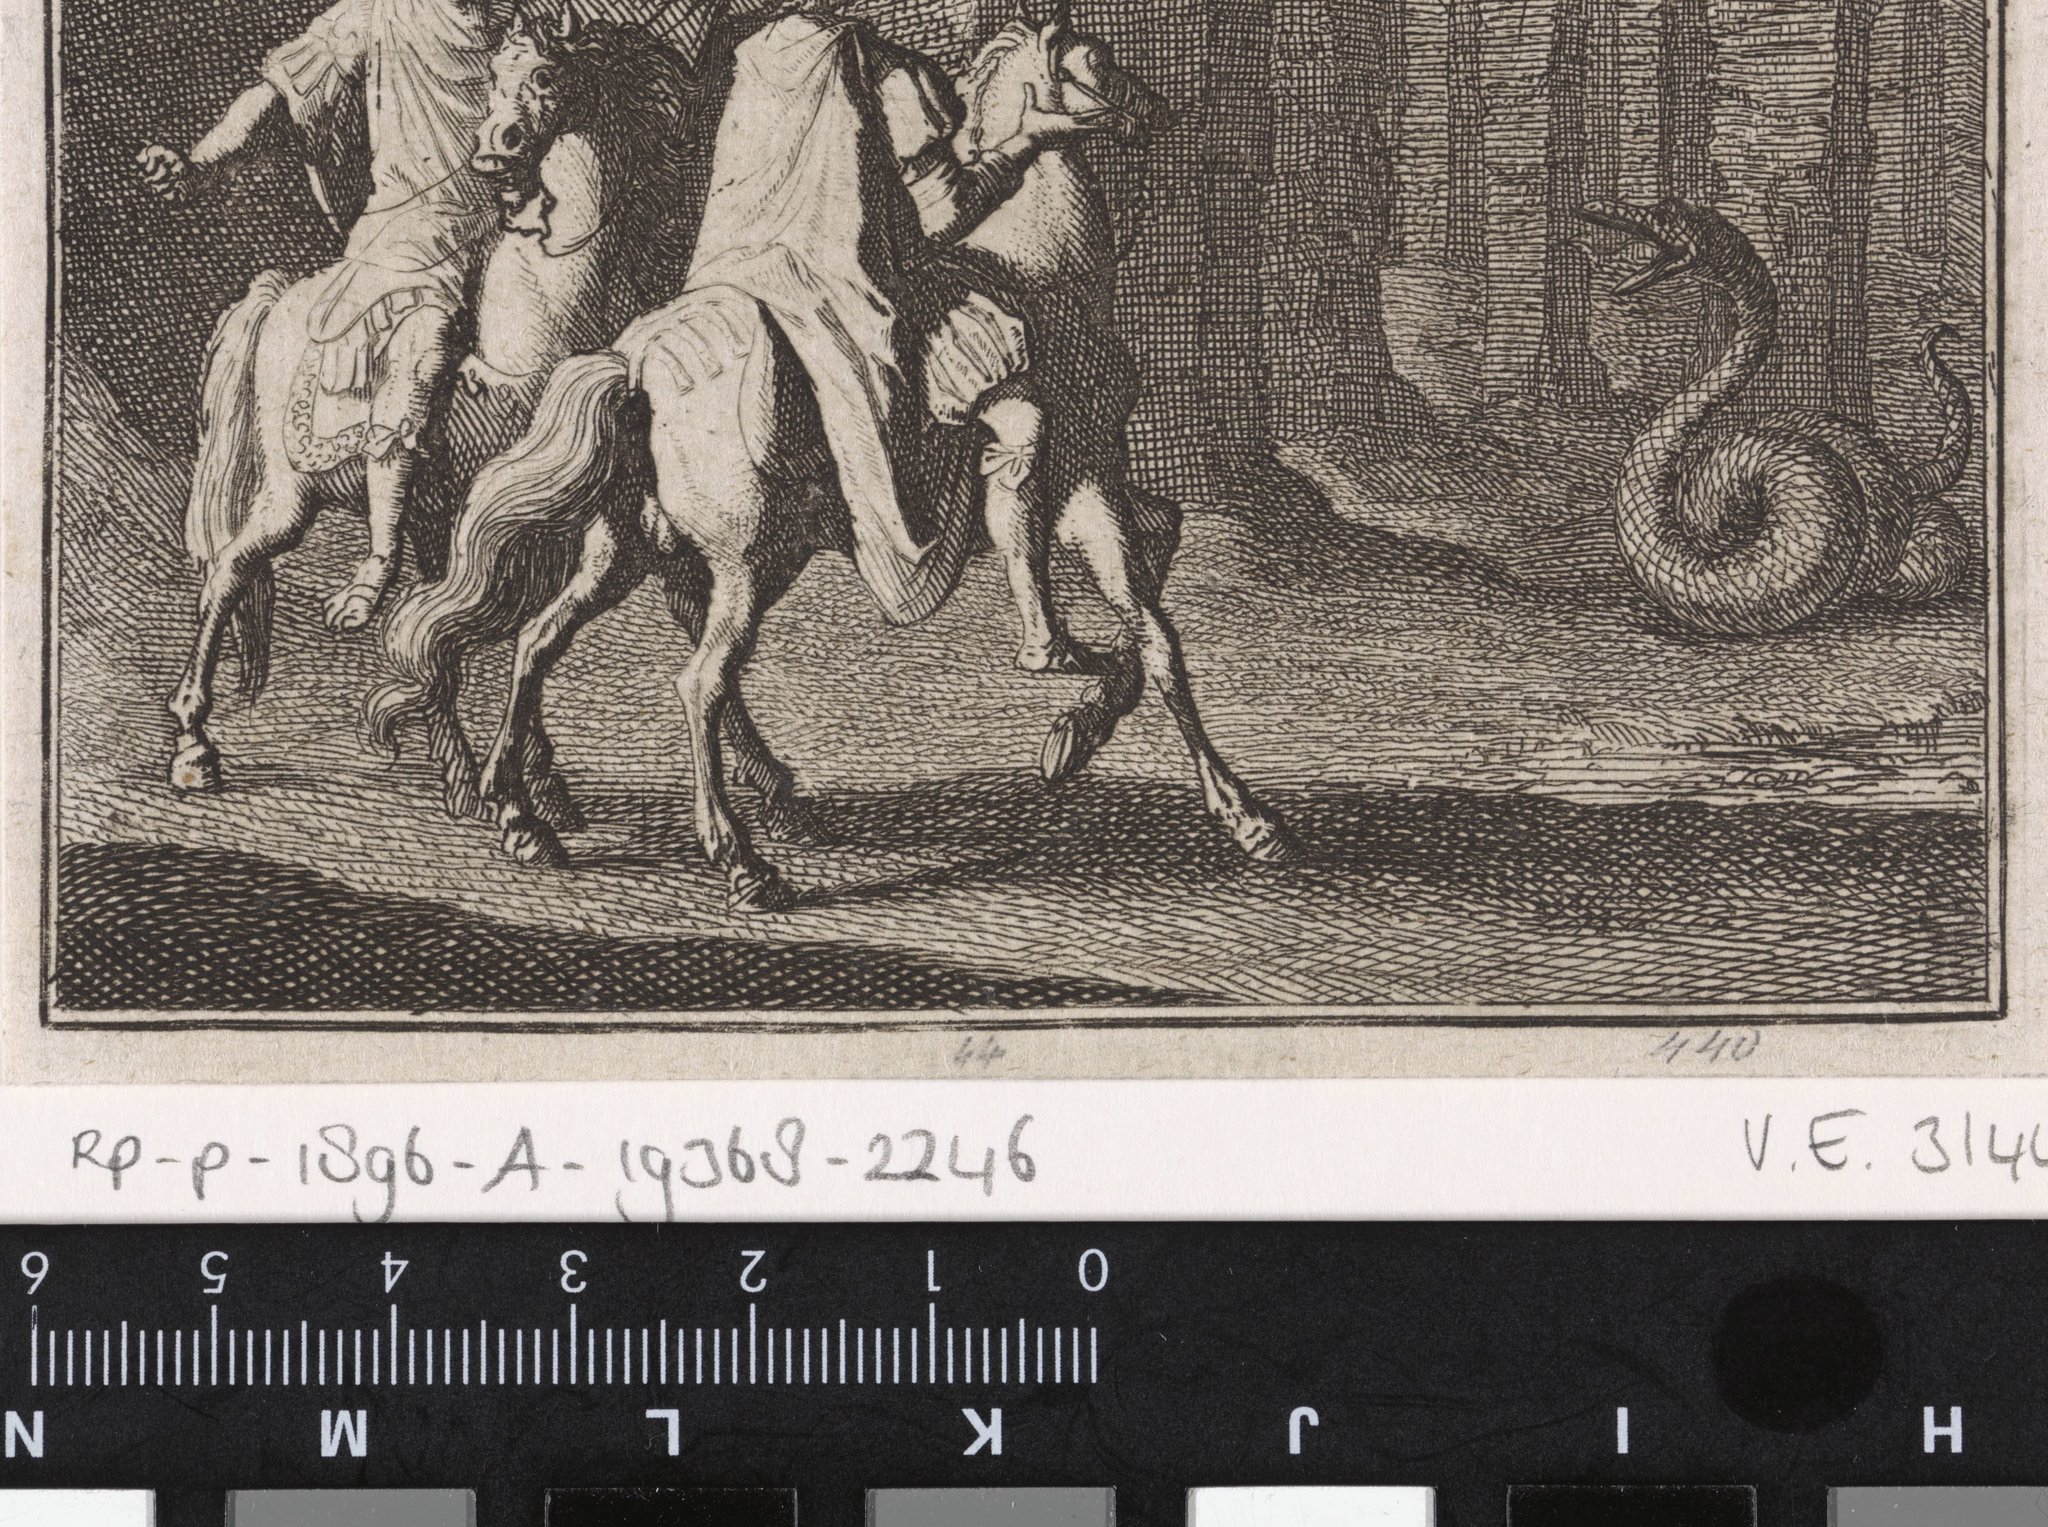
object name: book illustration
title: Koningen van Frankrijk en Engeland worden opgeschrikt door een als slang vermomde duivel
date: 1704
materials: paper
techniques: etching, letterpress printing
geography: nuremberg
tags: peace negotiations, devils in the form of (fabulous) animals, king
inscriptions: collector's mark: Lugt 2228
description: Illustratie uit: Abraham a Sancta Clara. Heilsames Gemisch Gemasch, das ist: Allerley seltsame und verwunderliche Geschichten (...). Neurenberg: Christoph Weigel, 1704, p. 440.